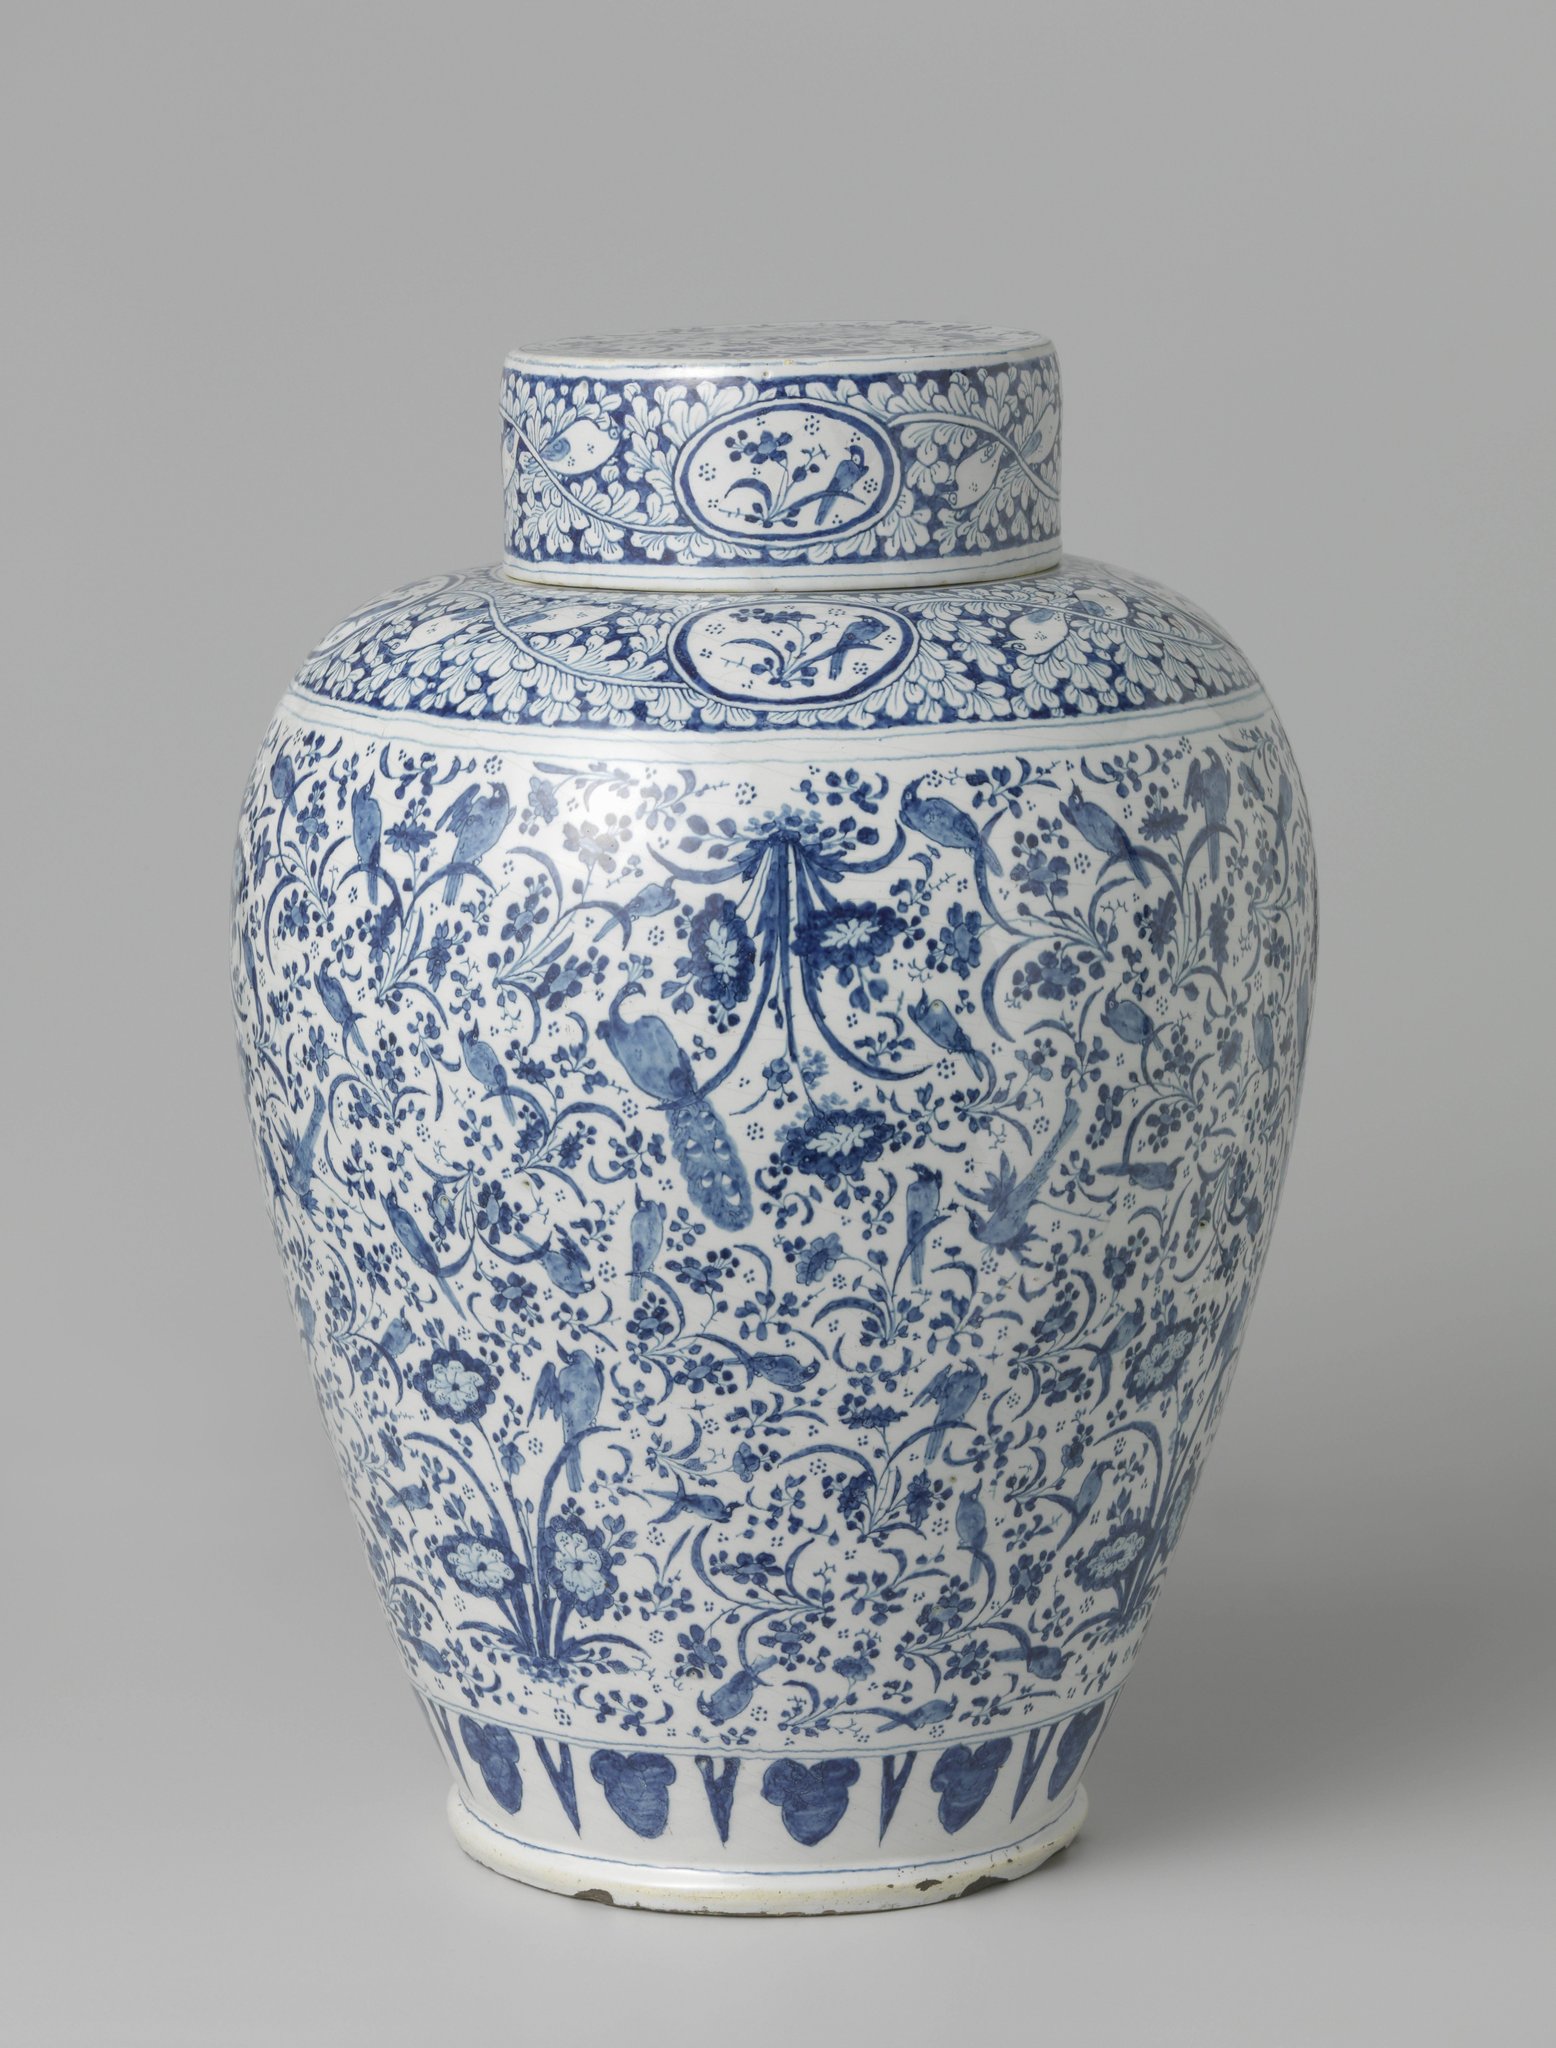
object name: covered jar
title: Lidded vase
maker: gerrit pietersz. kam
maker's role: plateelbakker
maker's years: -1705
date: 1695-1700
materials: earthenware, glaze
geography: delft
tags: floral interlace ~ ornament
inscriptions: mark: ‘GK (ineen)’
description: The free distribution of the flowers and branches over the body of the vase is based on examples of Asian ceramics and textiles. This floral motif recurs regularly on products from Gerrit Kam’s pottery factory.